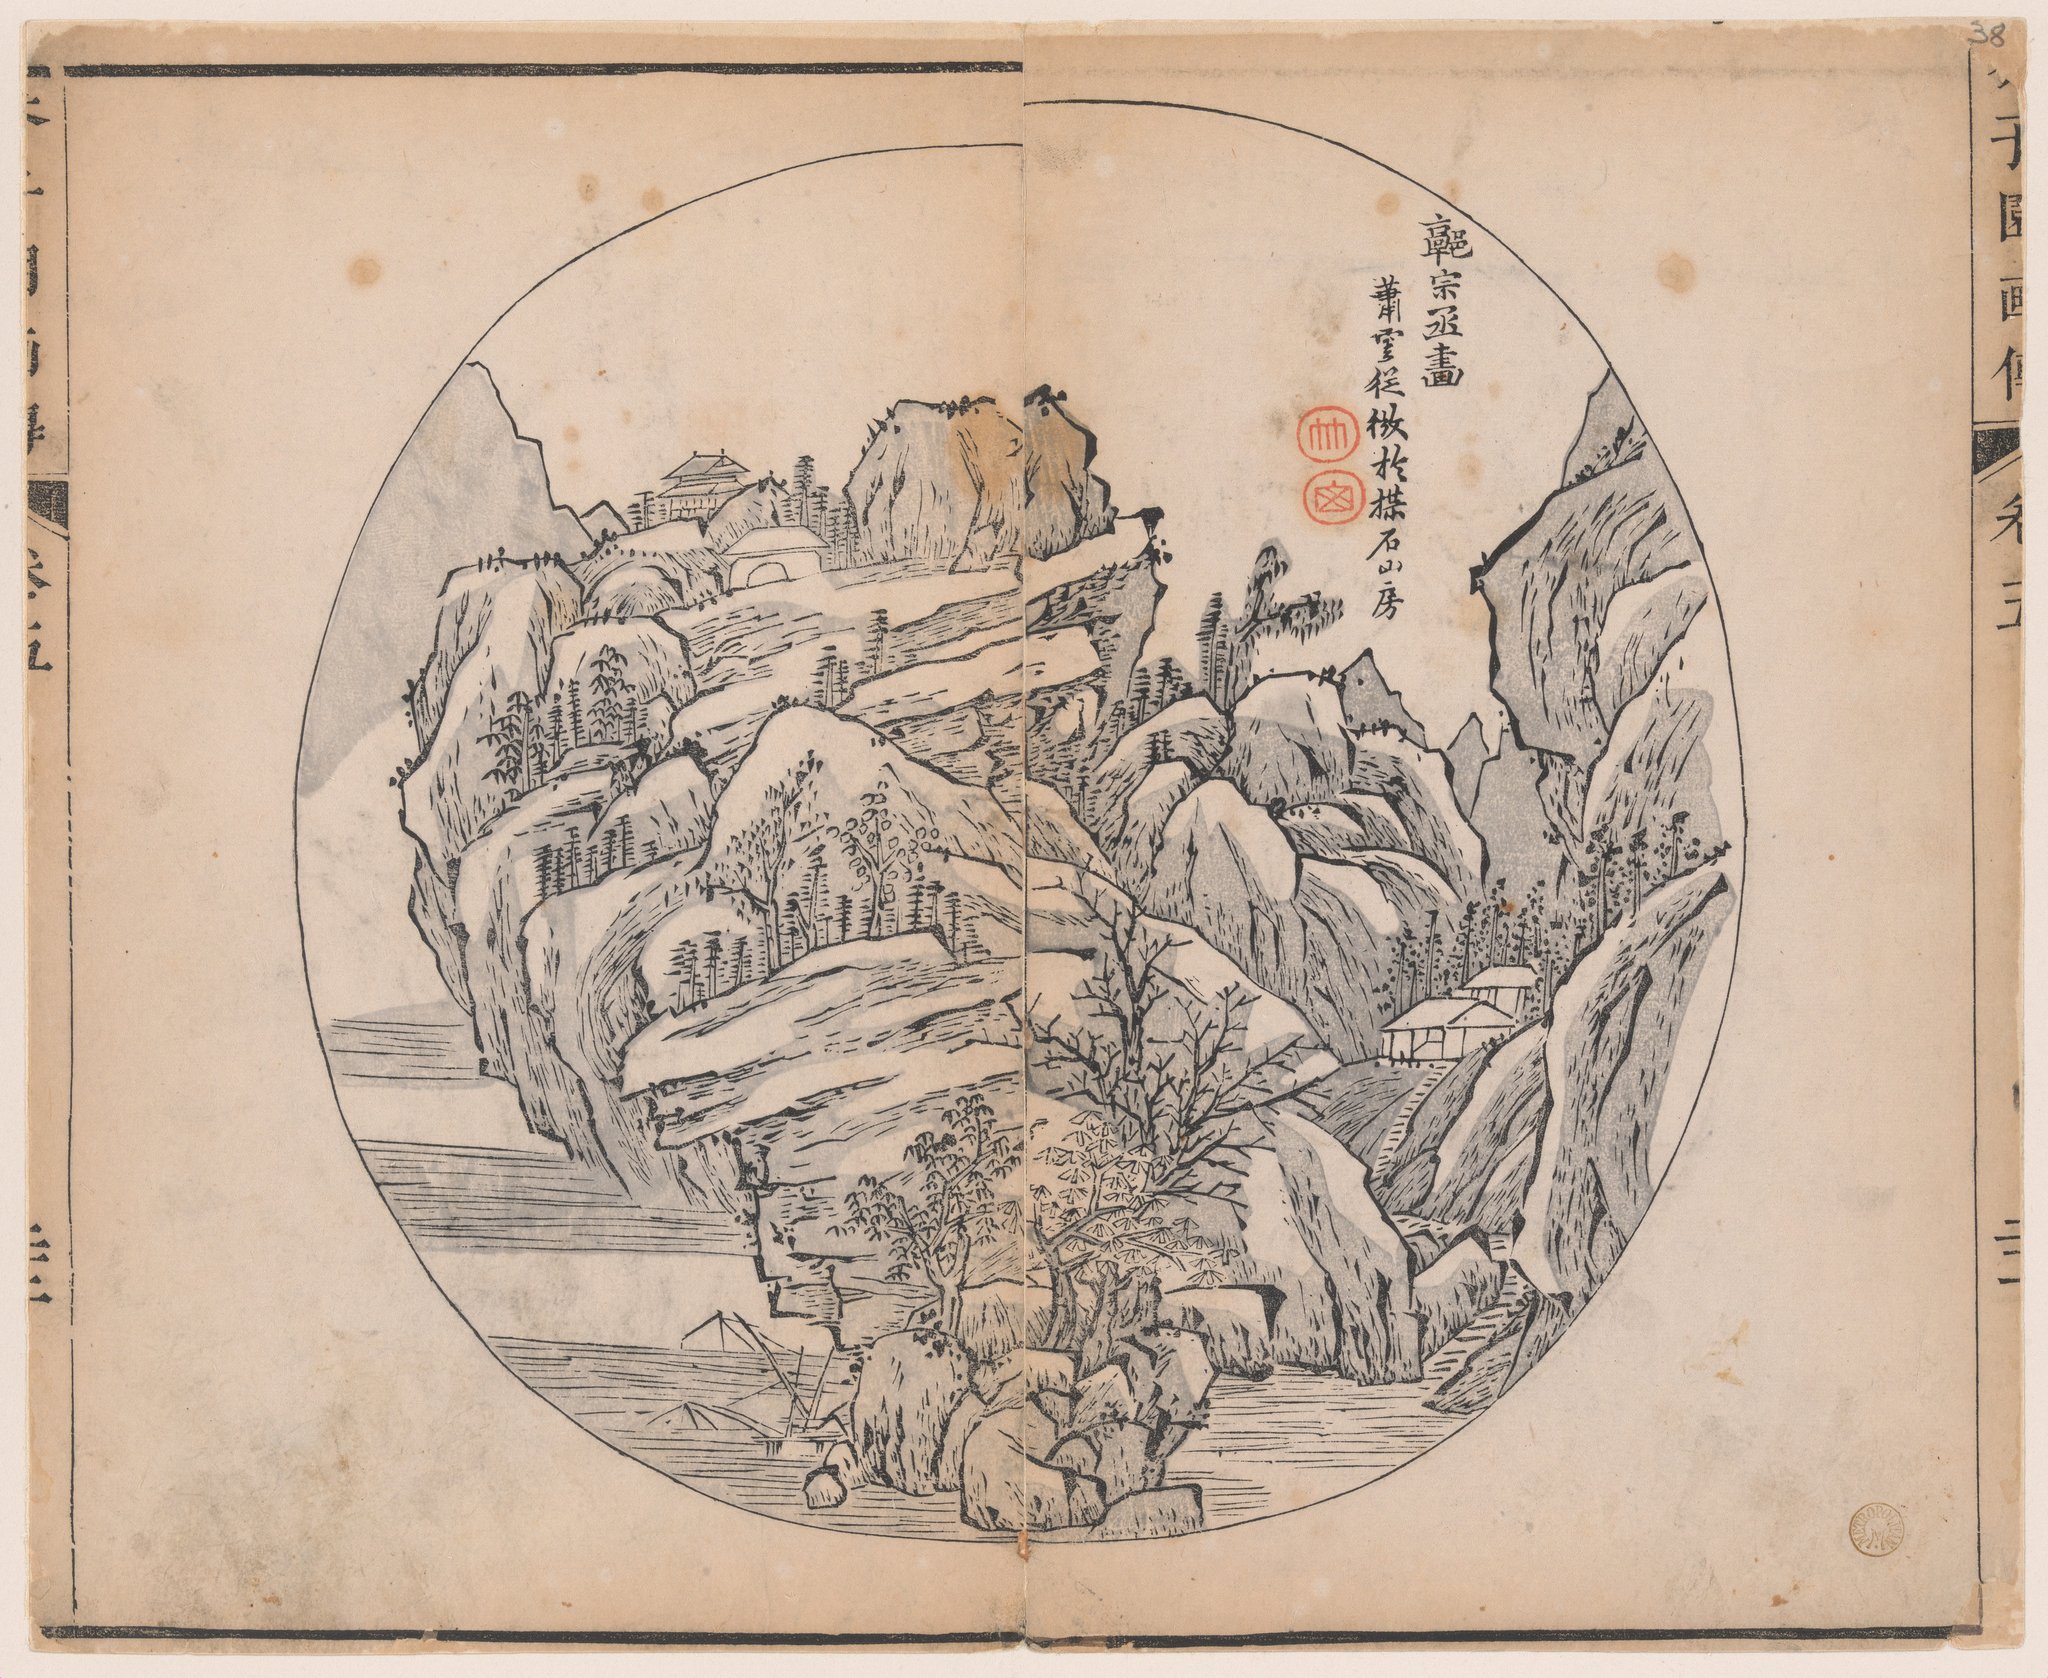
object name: print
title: Page from the Mustard Seed Garden Manual of Painting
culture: chinese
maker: wang gai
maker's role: artist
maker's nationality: chinese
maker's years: 1645-1710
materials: ink, paper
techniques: woodblock print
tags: mountains,landscapes